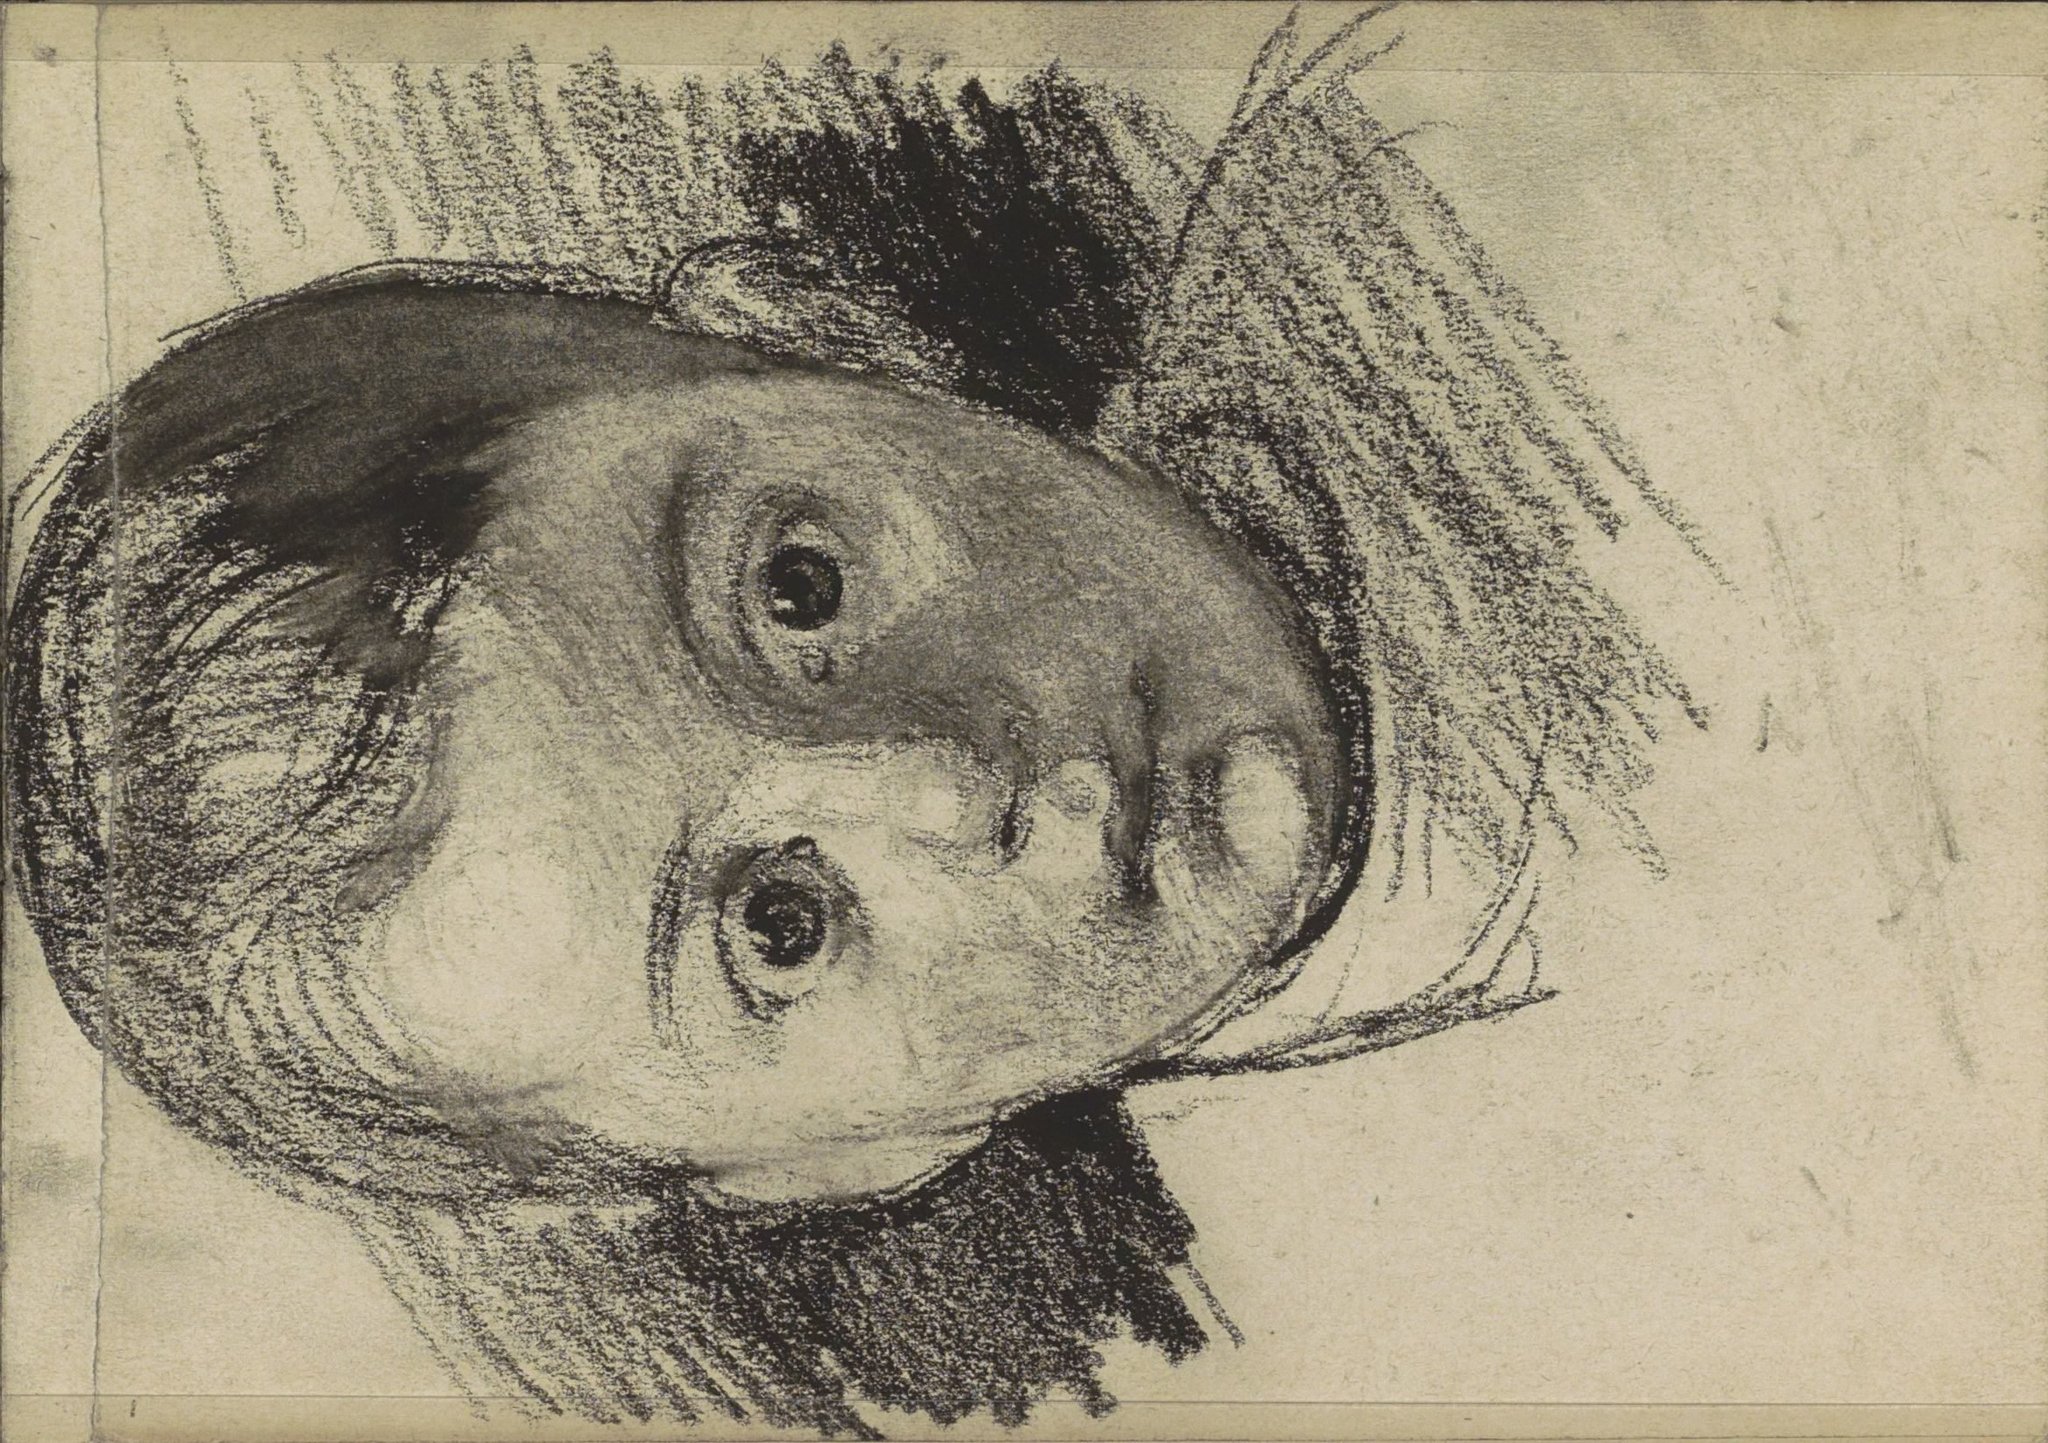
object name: sketchbook leaf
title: Buste van een jongen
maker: willem witsen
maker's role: draughtsman, painter, print maker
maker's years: 1860-1923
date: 1906-1907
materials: chalk, paper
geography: wijk bij duurstede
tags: girl (child between toddler and youth)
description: Pagina 1 uit een schetsboek met 25 bladen.